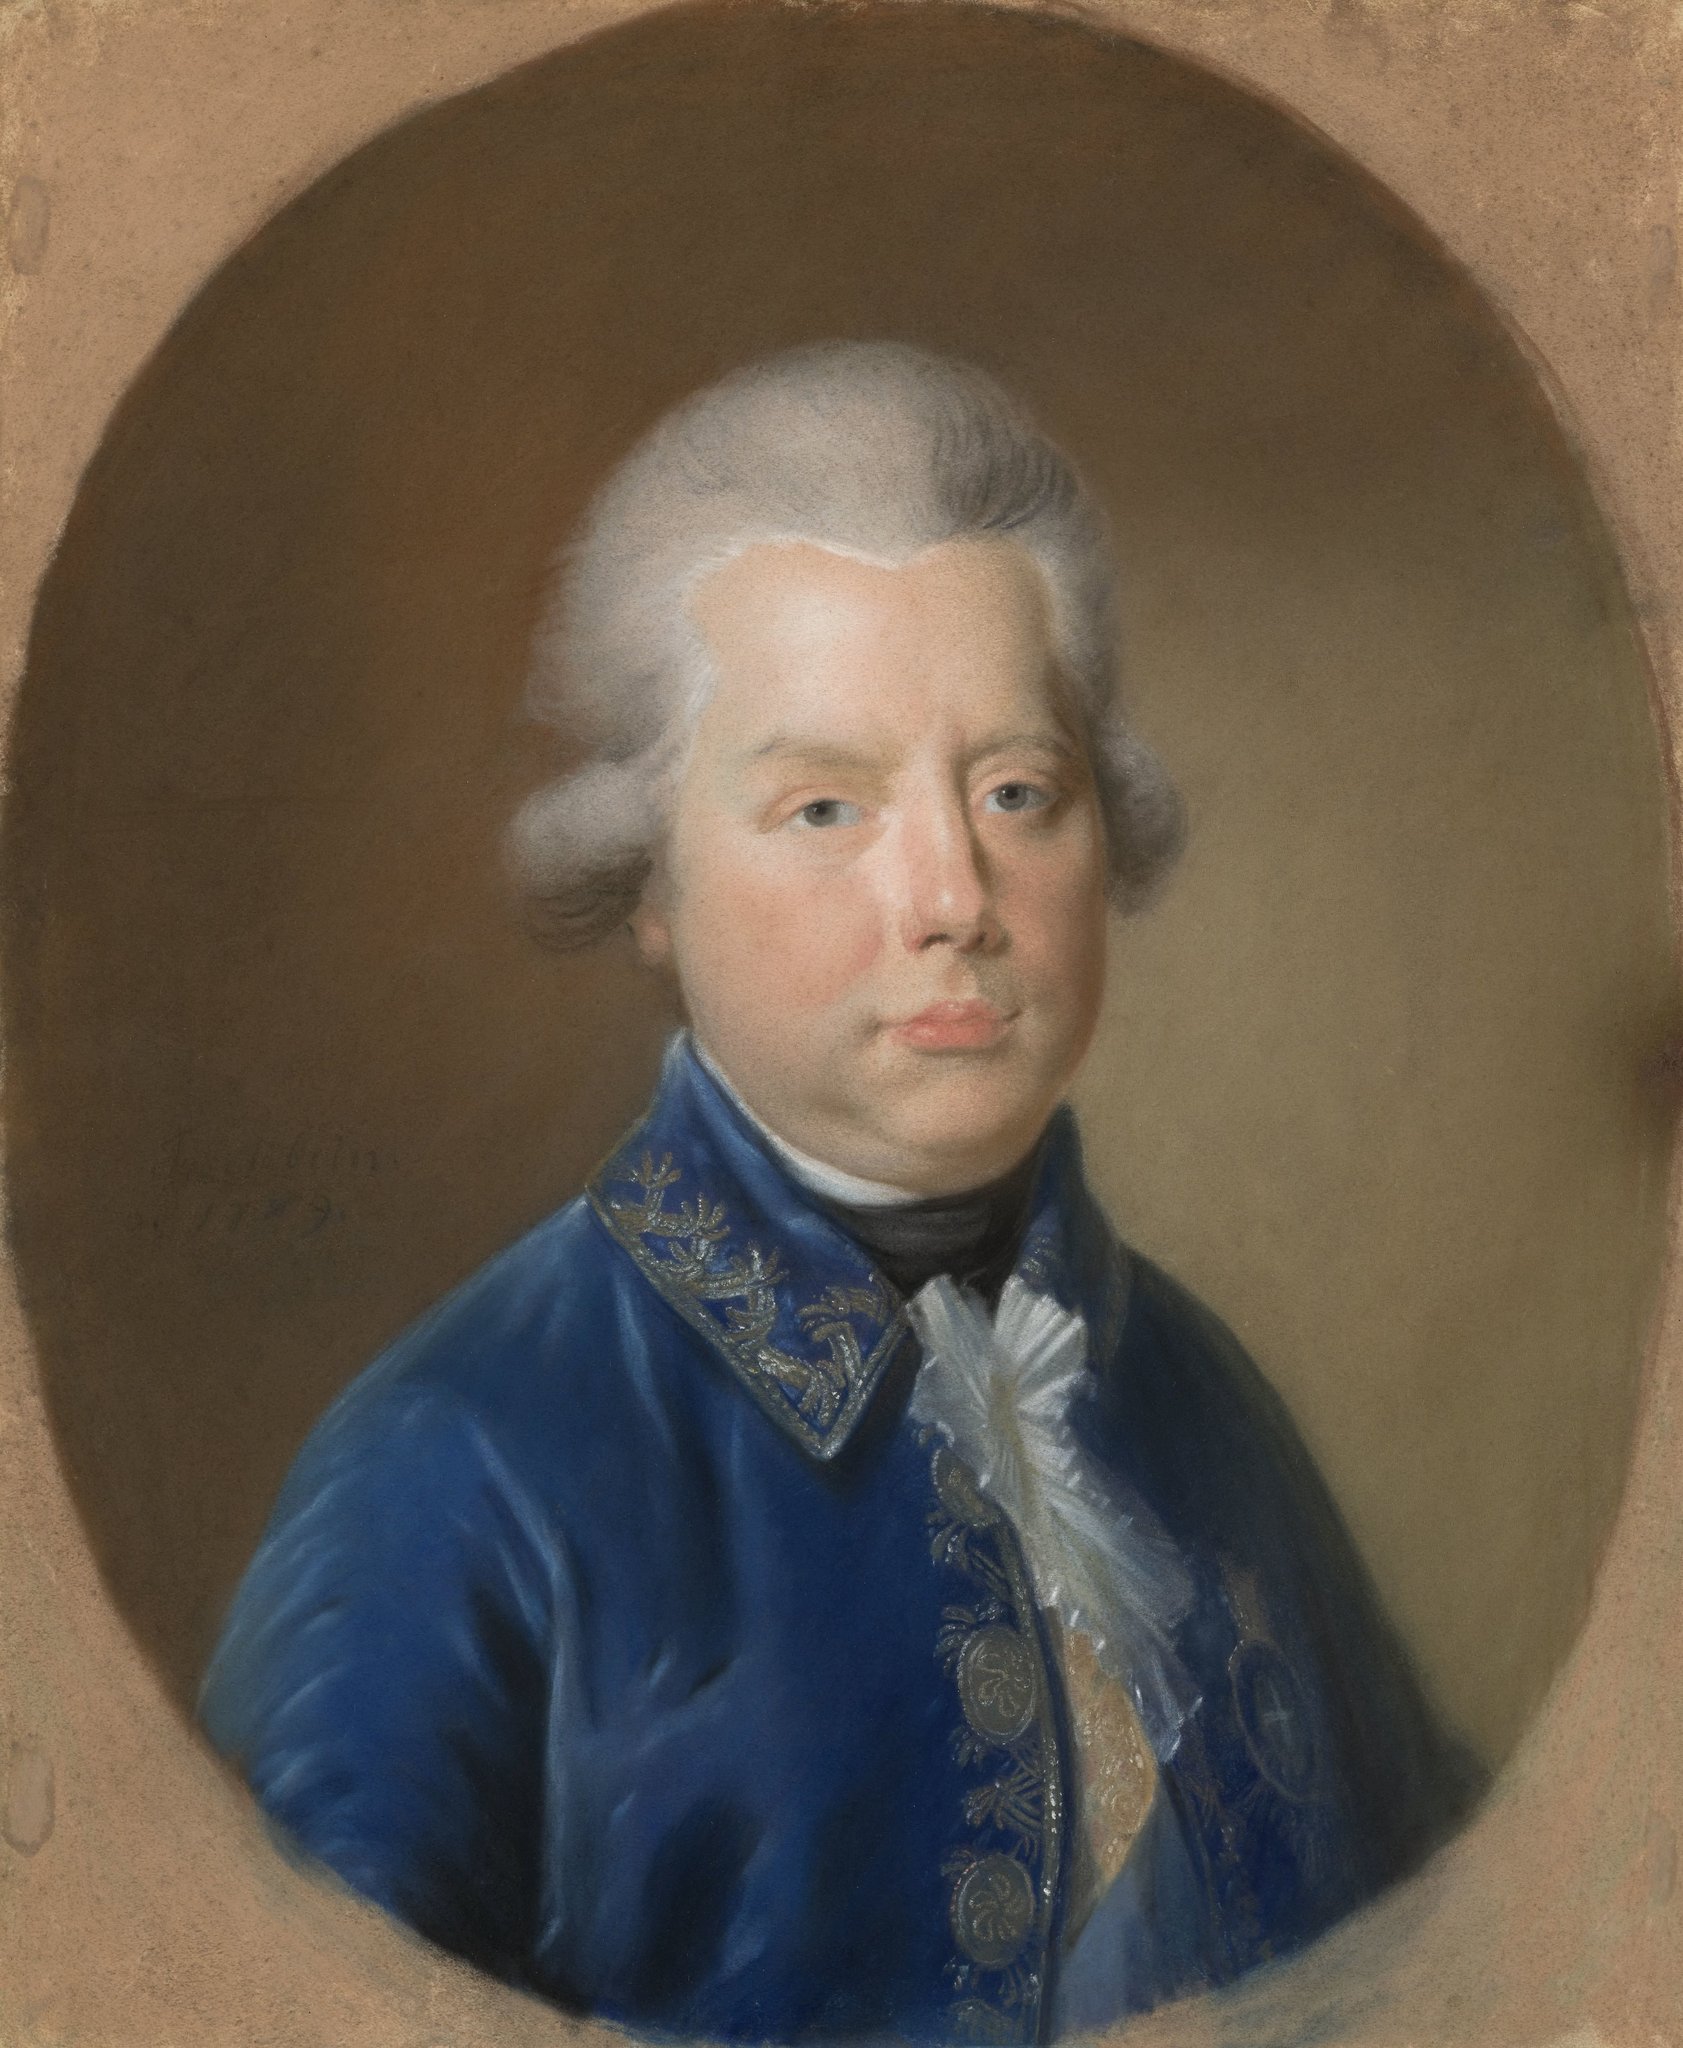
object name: drawing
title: Stadtholder Prince William v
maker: johann friedrich august tischbein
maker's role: painter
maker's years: 1750-1812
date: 1789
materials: parchment, pastel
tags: the hague, william v (prince of orange), historical persons (+ (full) bust portrait)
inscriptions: signature and date: ‘Tischbein 1789’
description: Under pressure from fierce opposition to his rule, Stadtholder William V and his family fled The Hague in 1785. They returned two years later and the stadtholder’s authority was restored. This provided the occasion to commission a series of portraits of the members of his family from the portraitist Tischbein. The artist produced a fashionable group of oval portraits in pastel. The giltwood frames were made by the Hague framemaker Hendrik Ebbens.